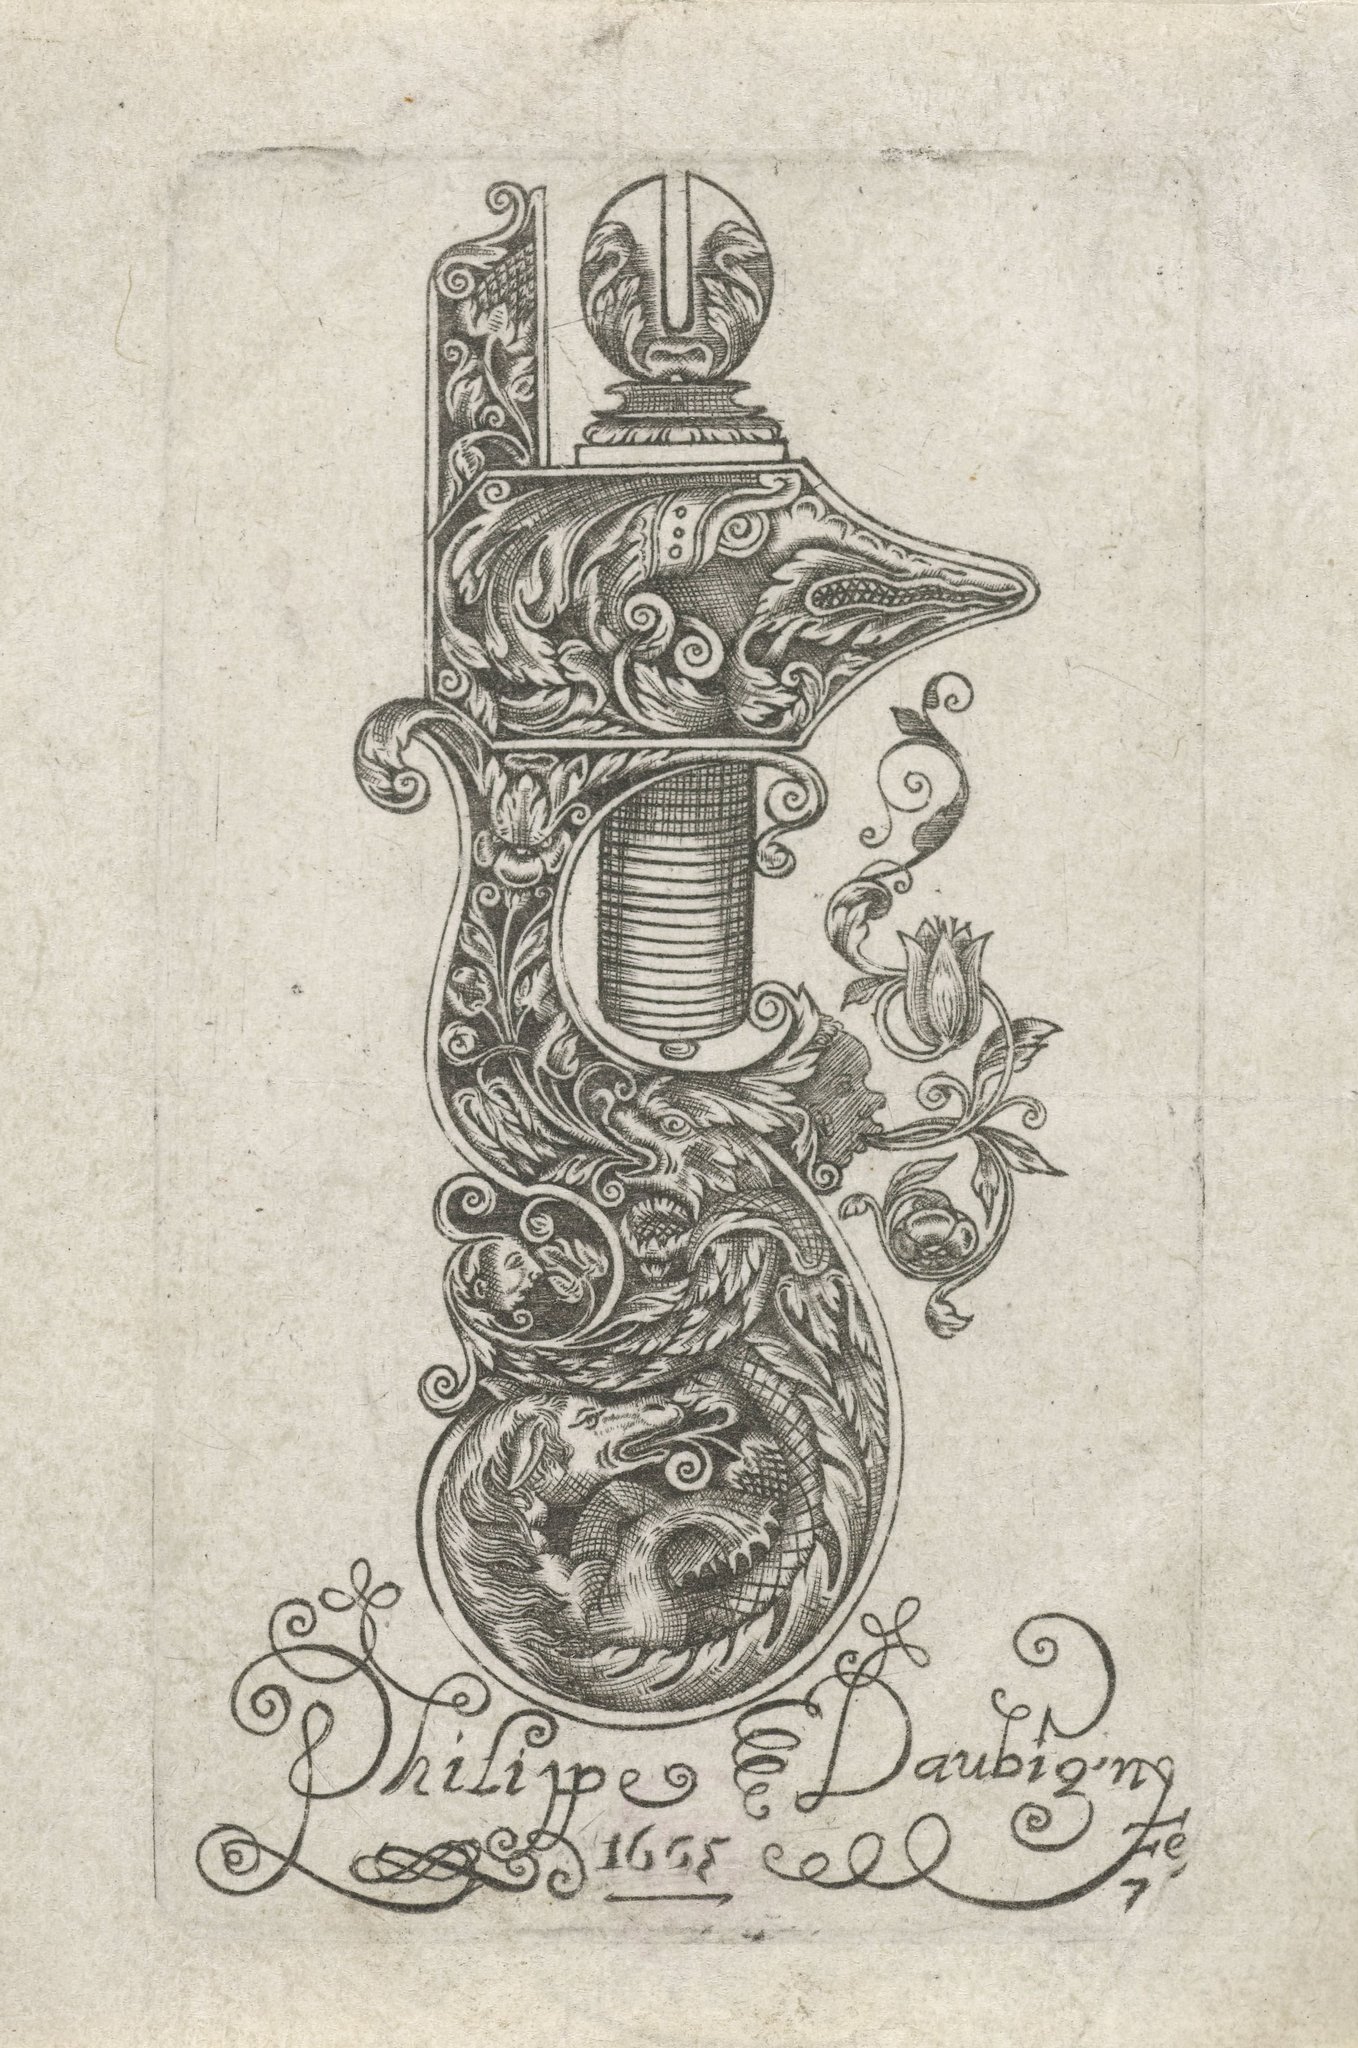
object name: ornament print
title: Zwartornamenten voor wapensmeden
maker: philippe cordier daubigny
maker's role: print maker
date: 1665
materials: paper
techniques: etching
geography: paris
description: Gedecoreerd met bladranken en een draak. Blad uit een serie van 14. Derde editie.